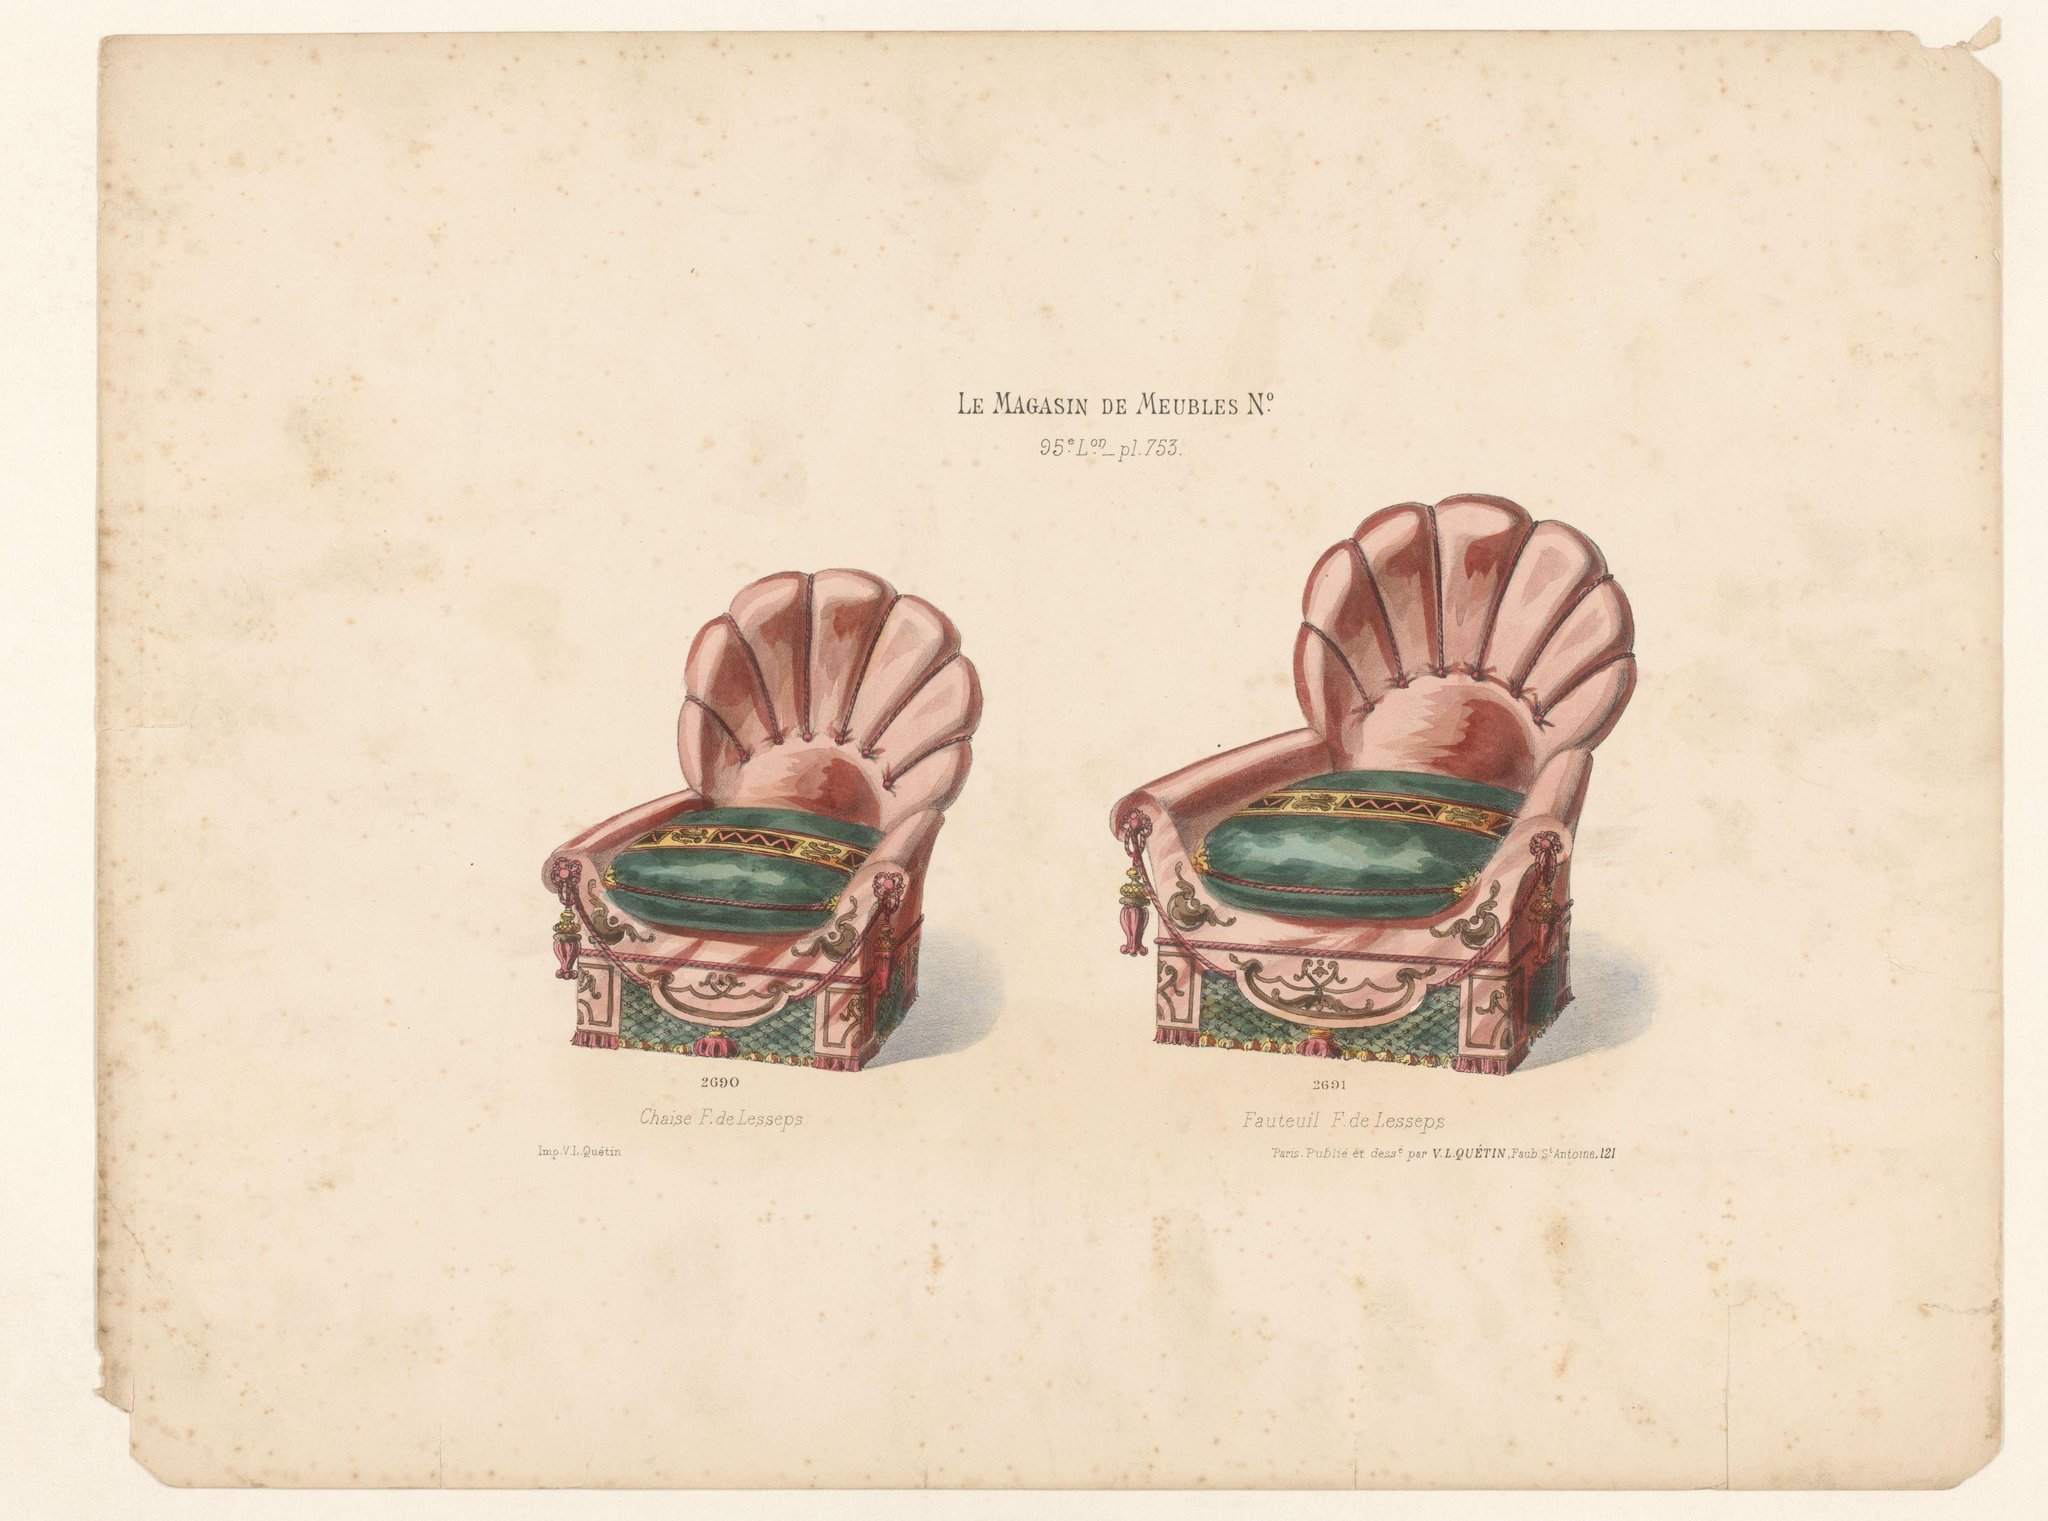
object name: print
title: Le Magasin de Meubles / No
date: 1878-1904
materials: paper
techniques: hand coloring, lithograph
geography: paris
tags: seating furniture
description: Een stoel en fauteuil. Prent uit 95e Livraison.